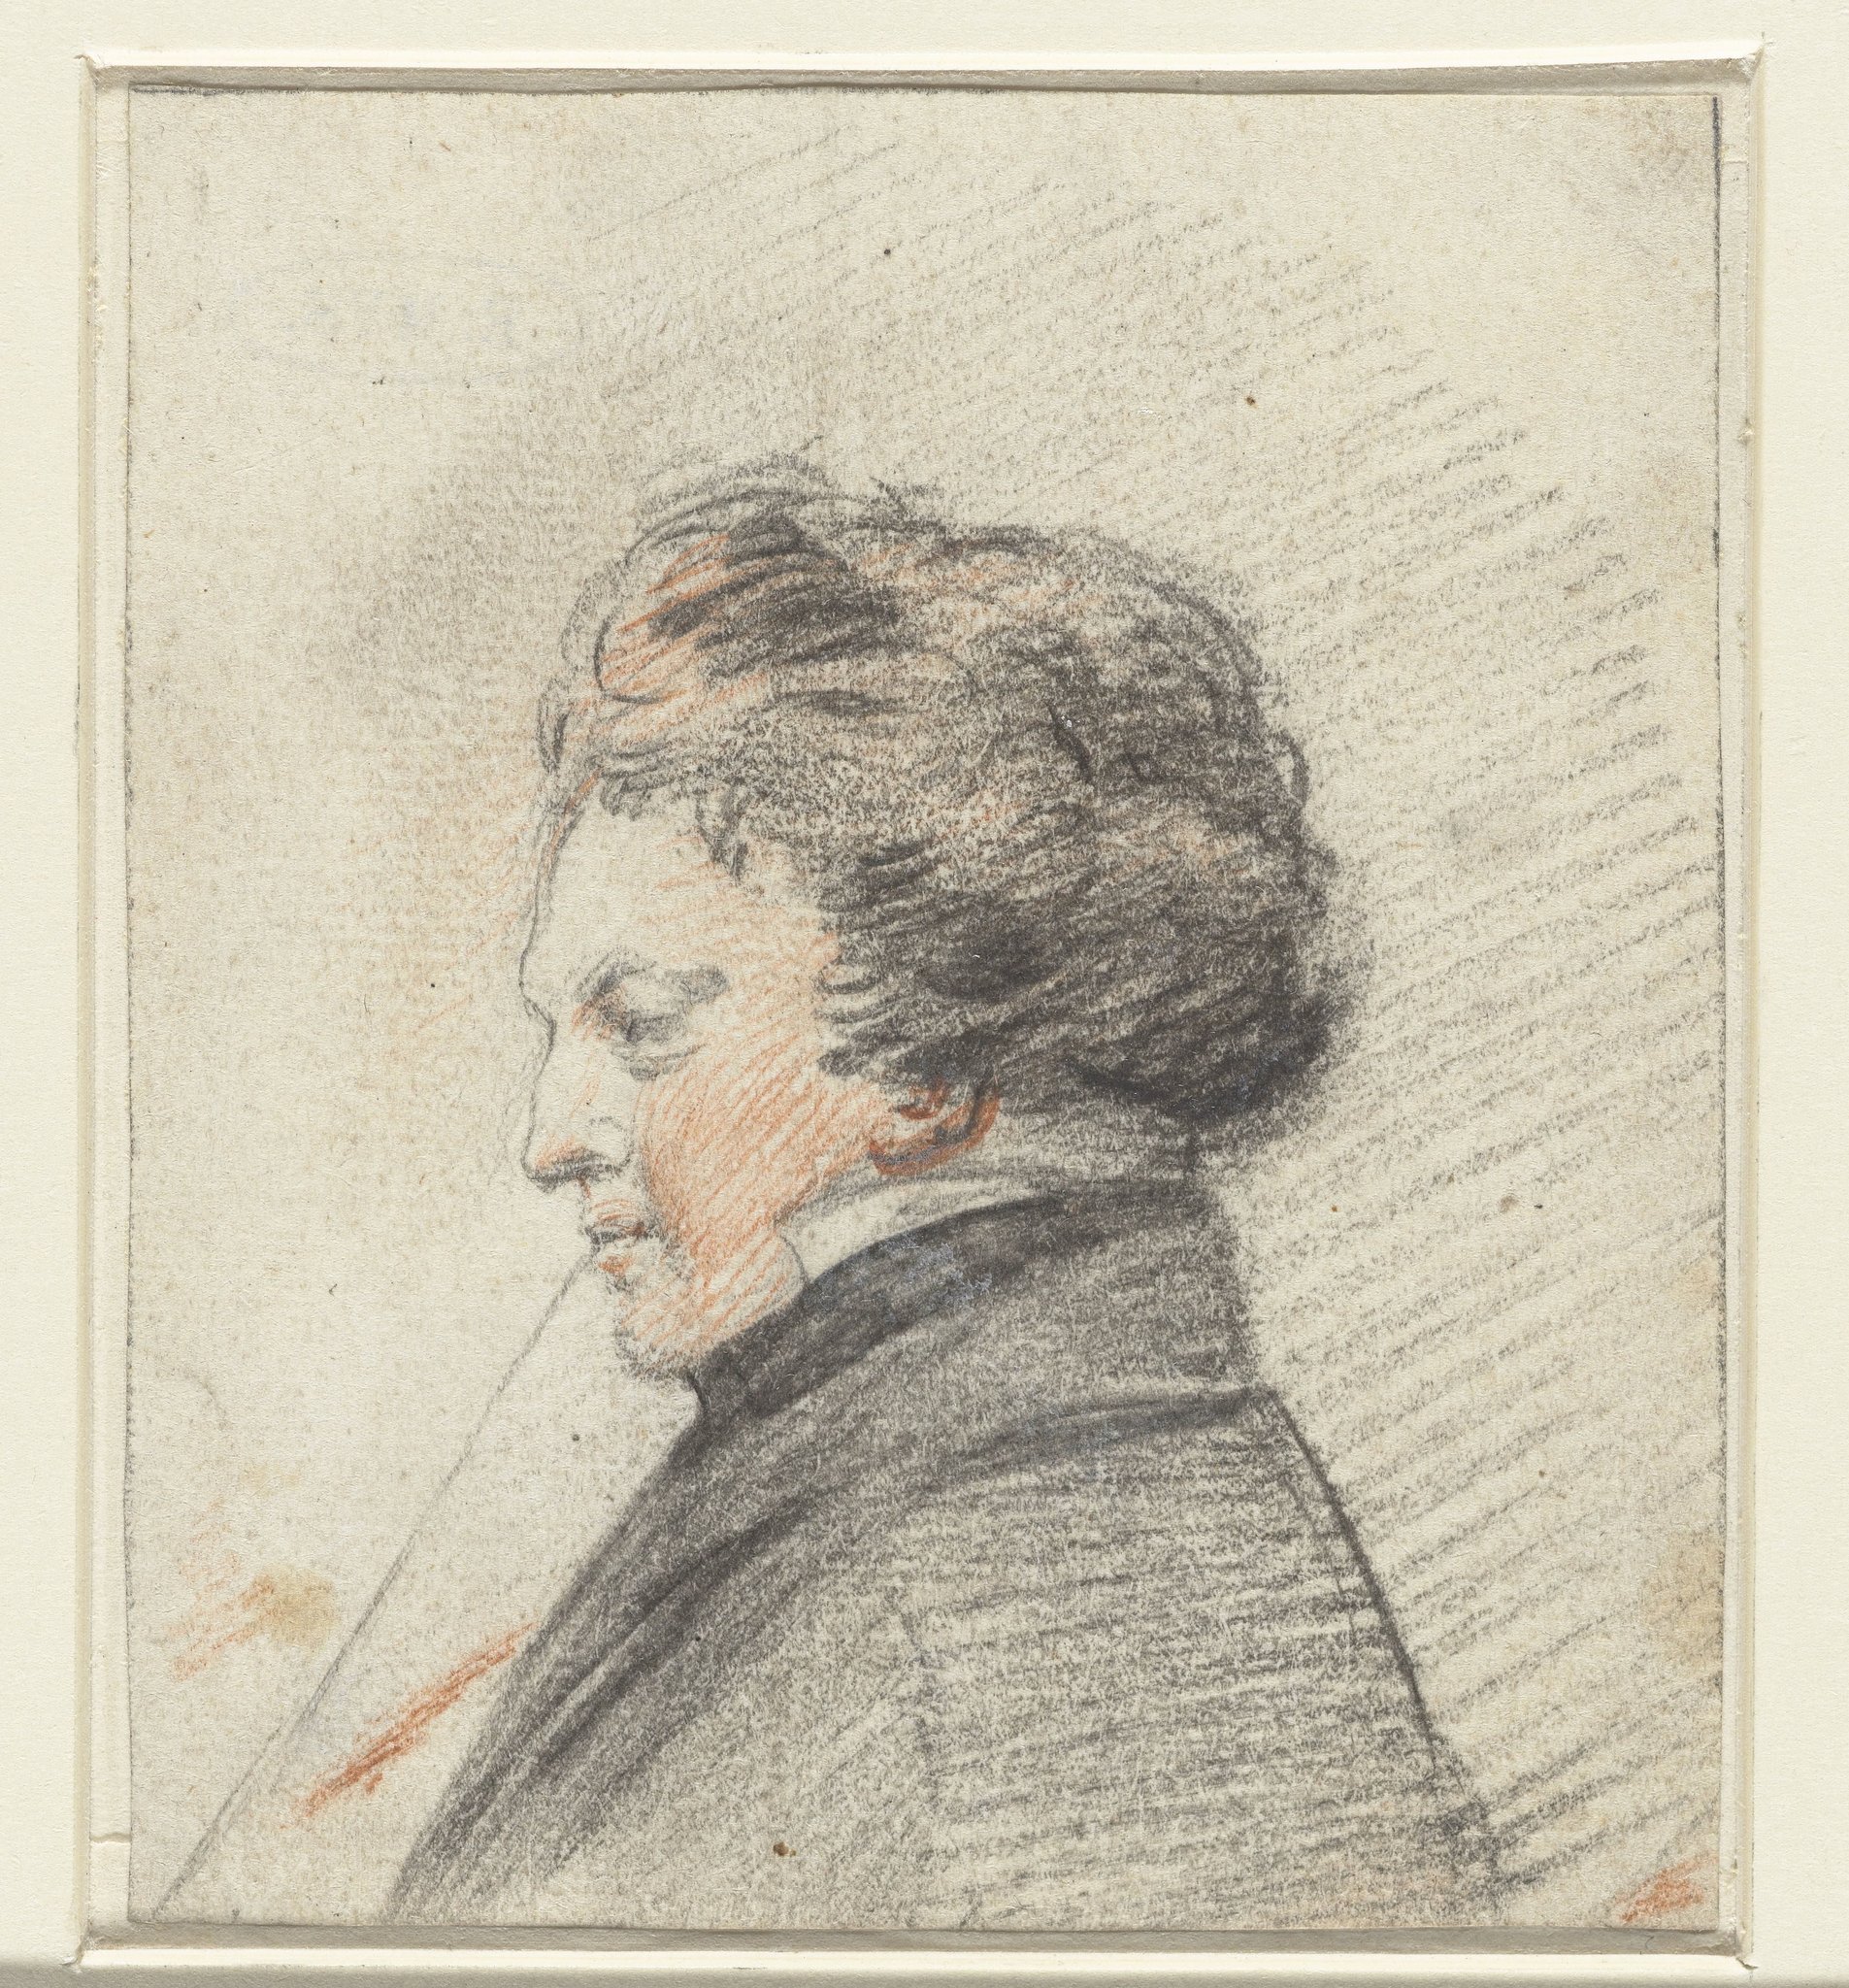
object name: drawing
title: Portret van Pieter Christoffel Wonder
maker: gijsbertus craeyvanger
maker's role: draughtsman, print maker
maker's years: 1810-1895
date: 1820-1895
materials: chalk, paper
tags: amsterdam, painter, print maker, draughtsman, pieter christoffel wonder, historical persons, portrait, self-portrait of artist, portrait, self-portrait of graphic artist, portrait, self-portrait of draughtsman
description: Portret van de tekenaar en graveur Pieter Christoffel Wonder.